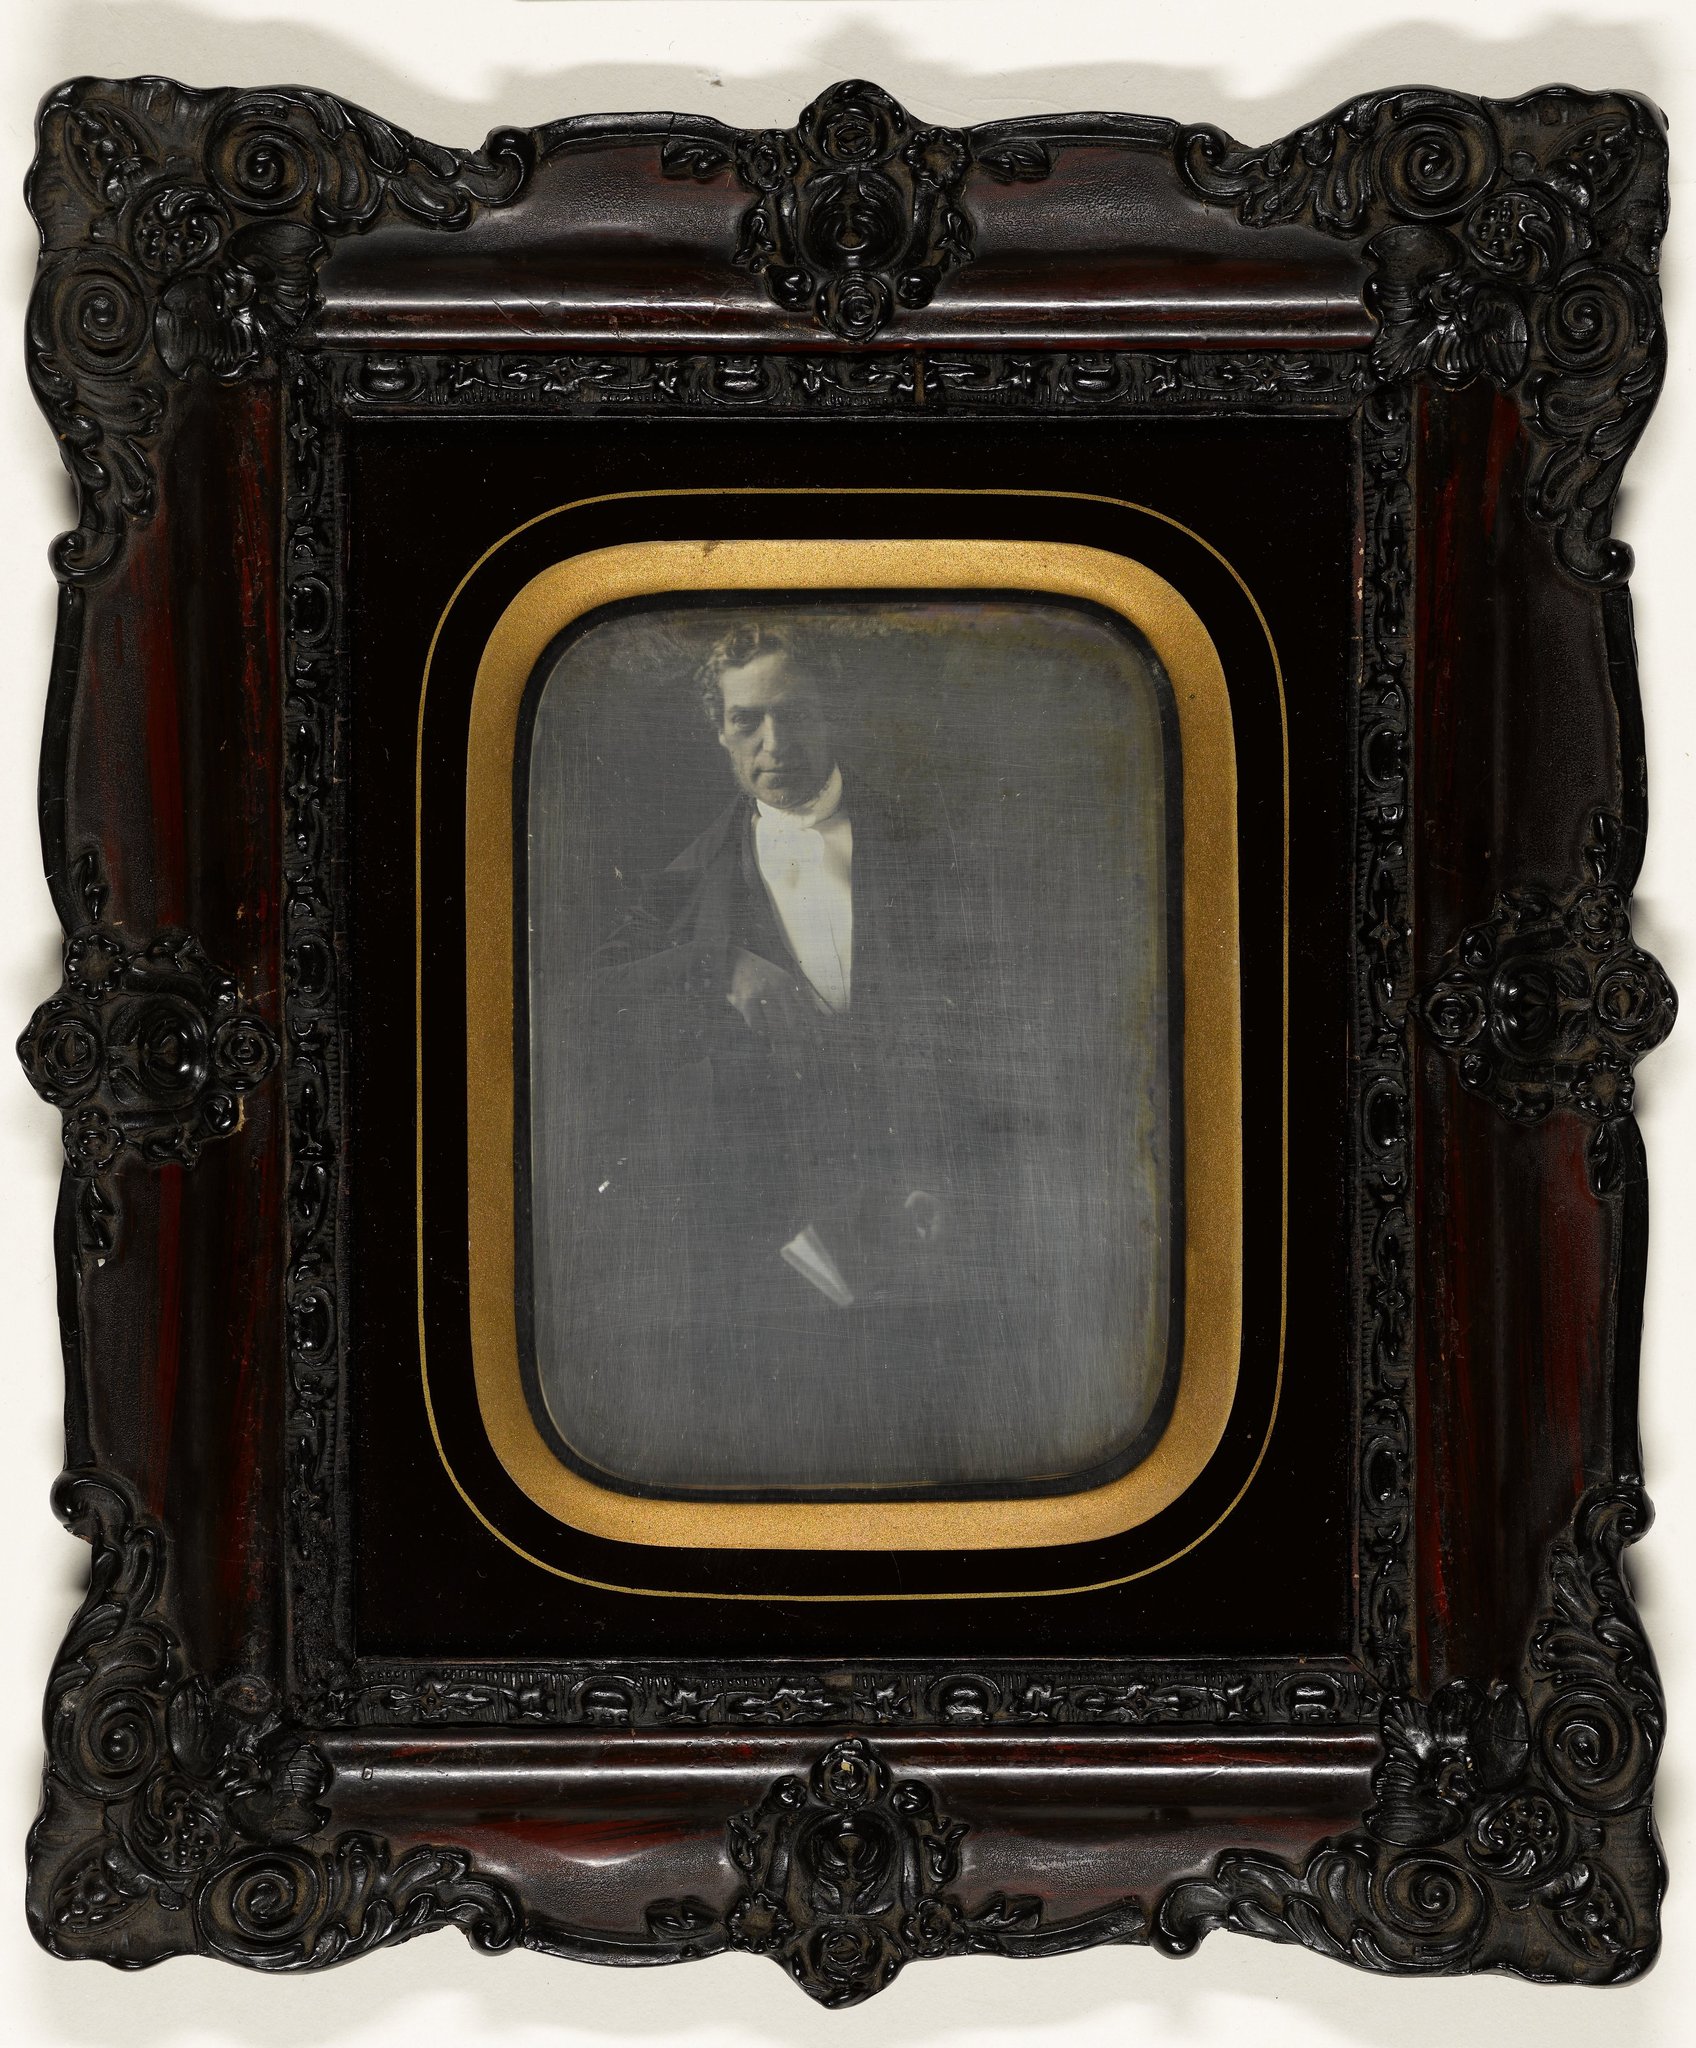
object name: frame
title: Portret van een onbekende man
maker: christoffel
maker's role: fotograaf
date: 1850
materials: copper, glass, wood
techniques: daguerreotype, hand coloring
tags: adult man, historical persons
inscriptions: inscription: ‘Anoniem/ Daguerreotypie +/- 1850/ 9.9 x 13 cm/ ziverkleur links boven;/ Christoffel/ Gerestaureerd 1969/ met thio ureum/ Franse Daguerreotypie’